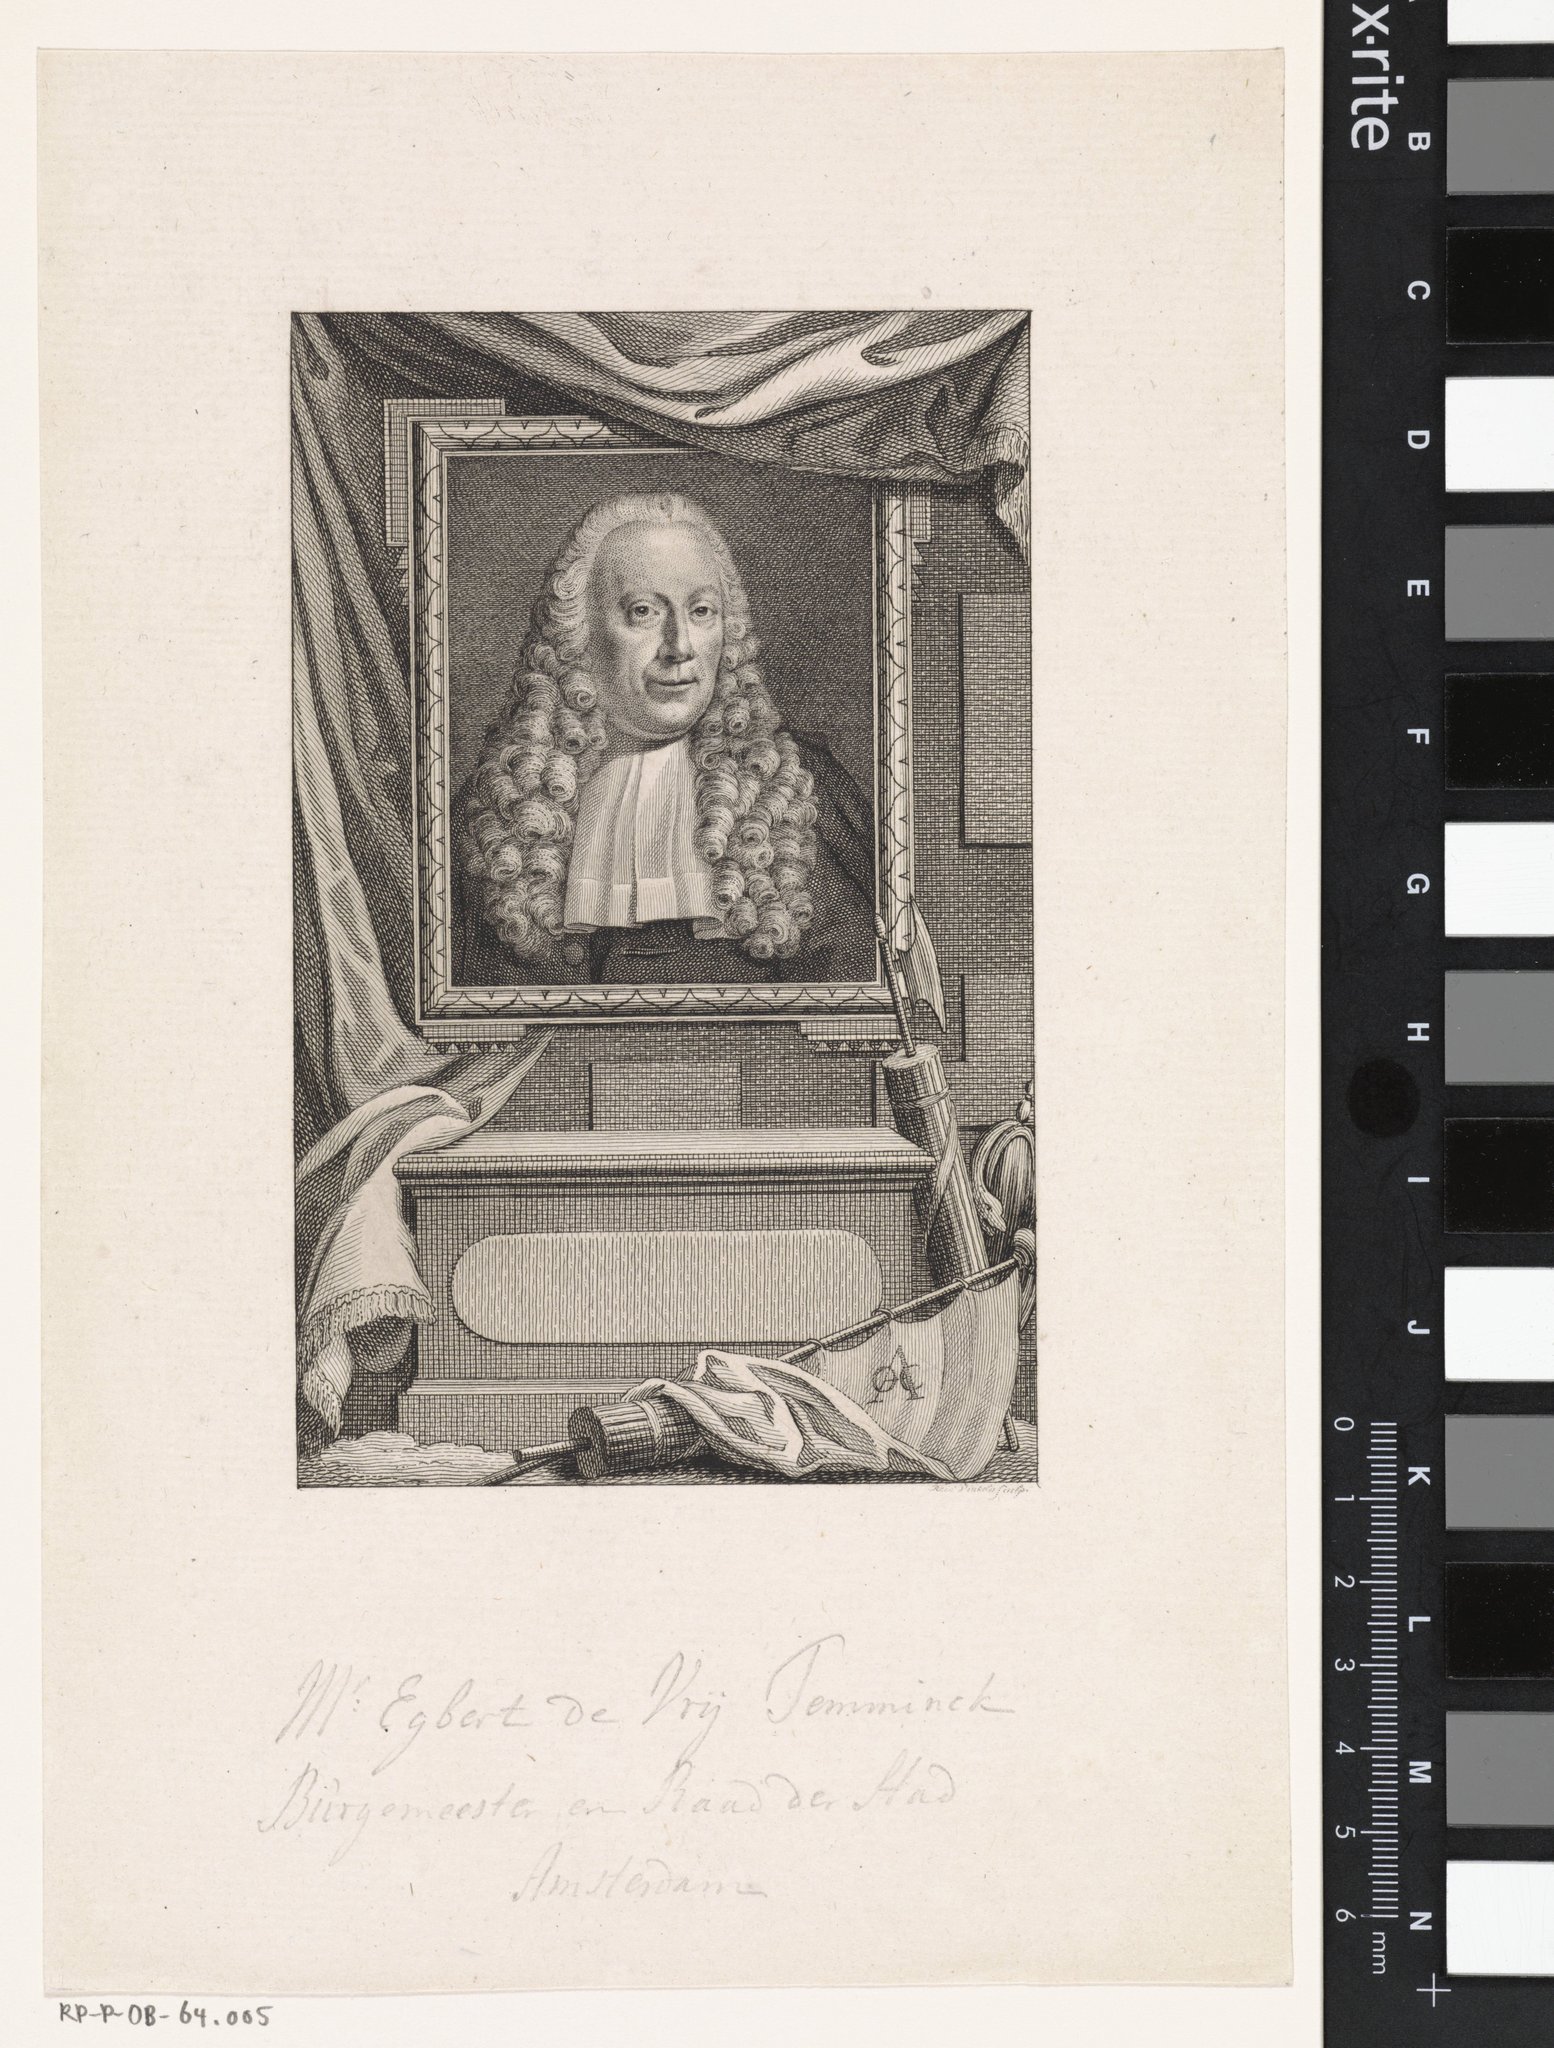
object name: print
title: Portret van Egbert de Vrij Temminck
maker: reinier vinkeles (i)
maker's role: draughtsman, print maker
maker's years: 1741-1816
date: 1786-1809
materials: paper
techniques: engraving, etching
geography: amsterdam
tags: mayor, egbert de vrij temminck, symbols and allegories of law; 'legge', 'legge civile' (ripa) (+ 'fasces cum securibus'), insignia of companies, etc.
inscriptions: collector's mark: Lugt 240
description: Latere staat prent ook gebruikt als boekillustratie in: Wagenaar, Jan. Vaderlandsche historie, (...) ten vervolge van Wagenaars Vaderlandsche historie. Dl. 1-43. Amsterdam: Johannes Allart, 1786-1809.